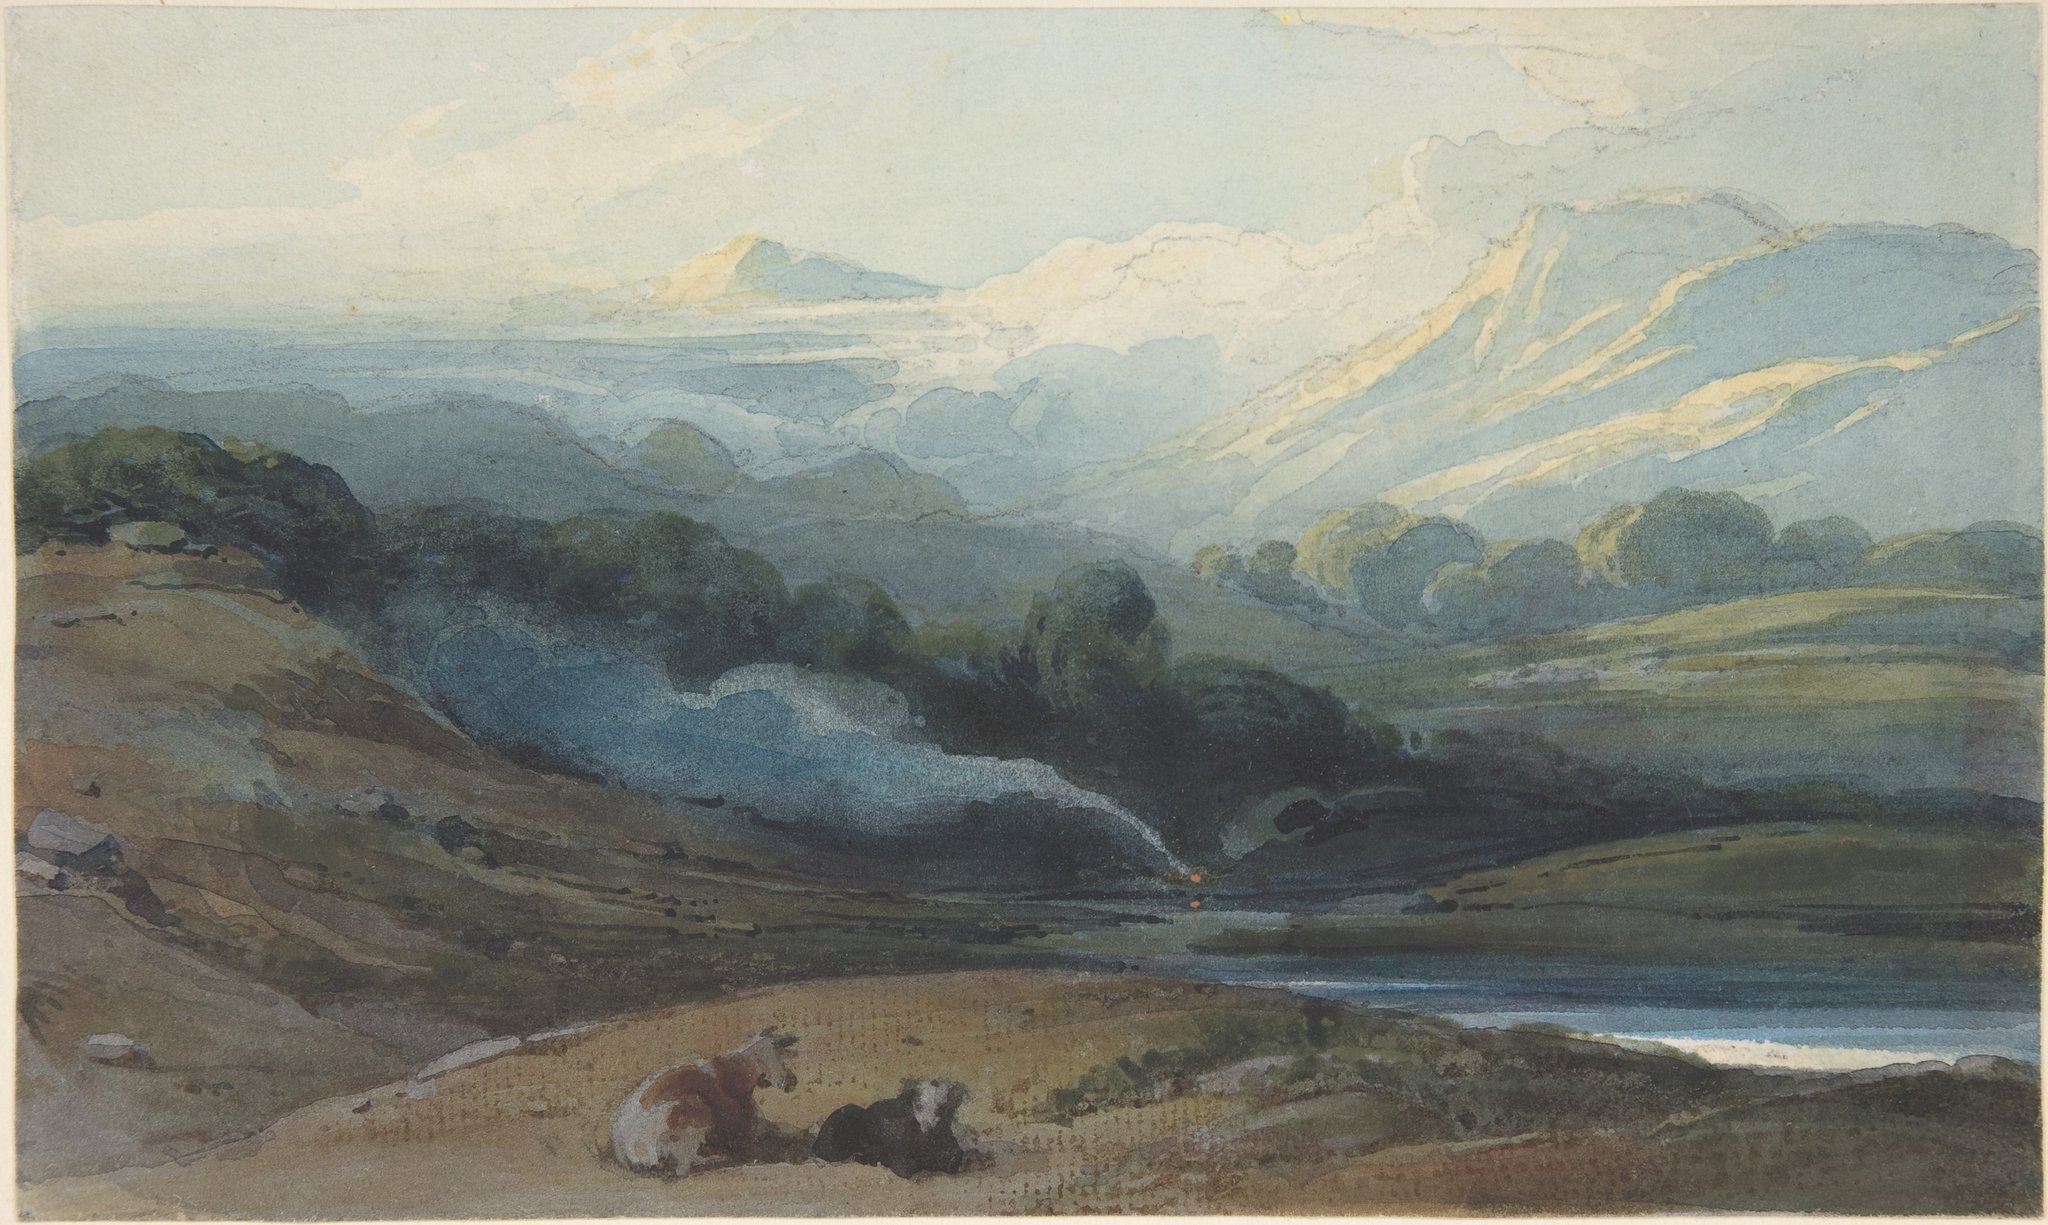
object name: drawing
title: Cattle resting in a mountainous landscape, Bengal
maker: george chinnery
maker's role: artist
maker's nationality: british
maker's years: 1774-1852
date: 1808-1812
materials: gouache, graphite, watercolor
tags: animals,mountains,landscapes